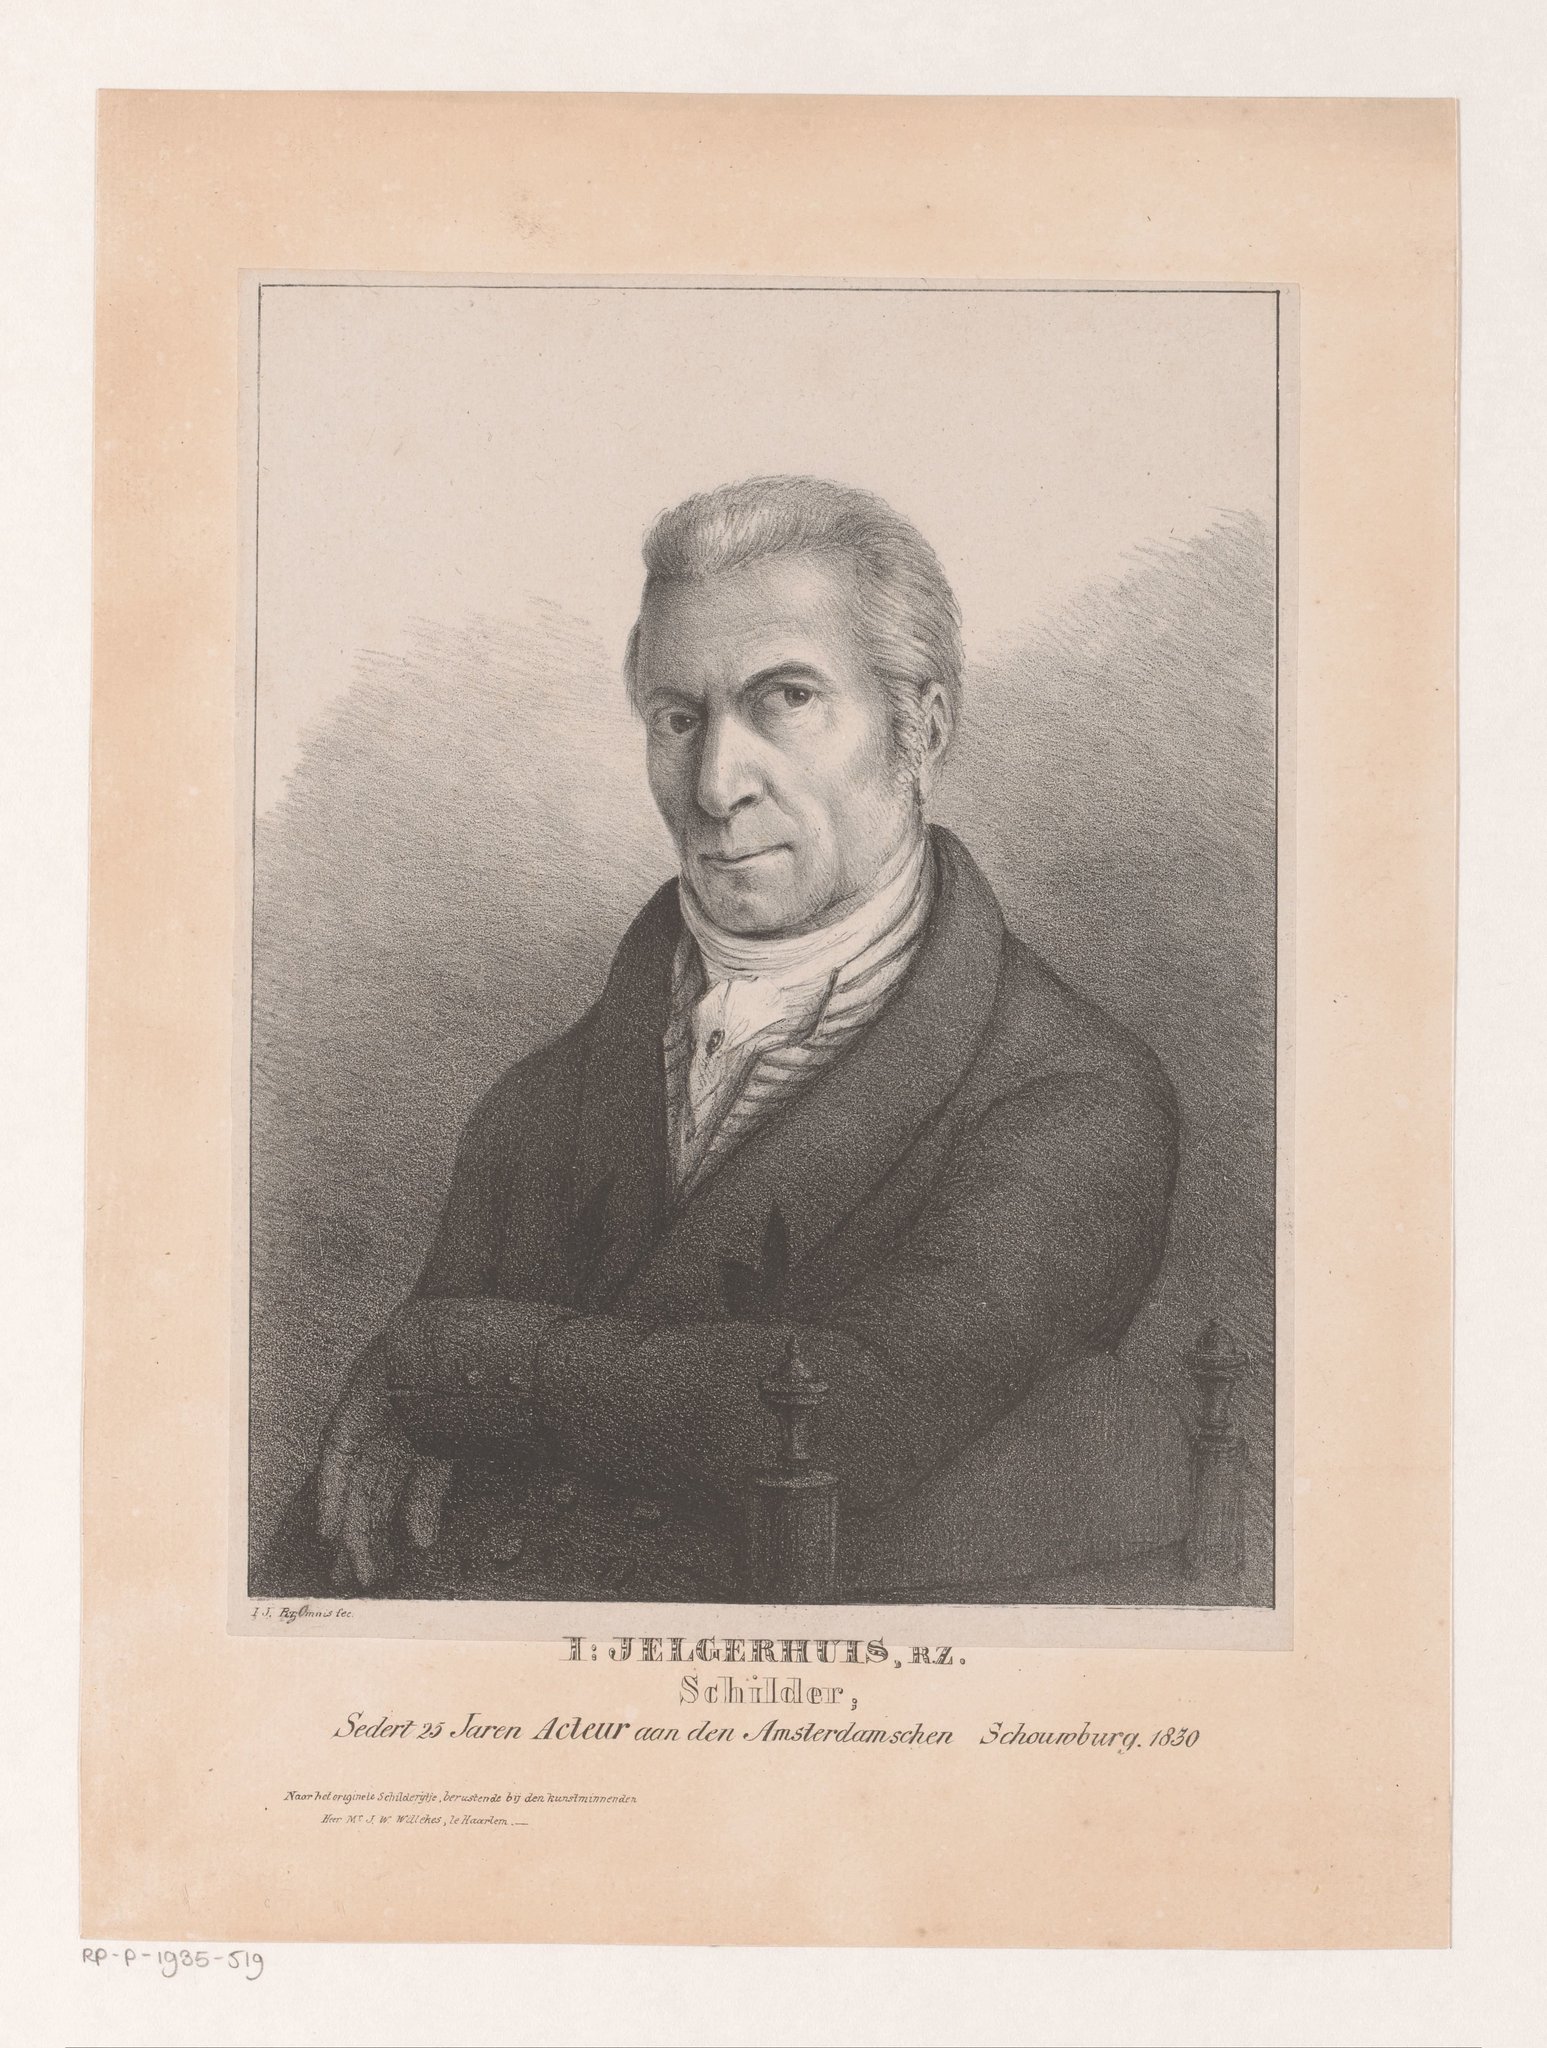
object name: print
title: Portret van Johannes Jelgerhuis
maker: johannes jelgerhuis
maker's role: draughtsman, painter, print maker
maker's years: 1770-1836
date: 1830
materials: paper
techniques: lithograph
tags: historical persons (+ half-length portrait)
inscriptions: inscription: ‘Van Buitenlandsche / als aandenken / van (...) / 17 january 1858 H. H. Zimmer(...)’, collector's mark: Lugt 2760, collector's mark: Lugt 2228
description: De geportretteerde leunt met zijn linkerarm op de rug van een stoel. Onder het portret zijn naam en beroep.